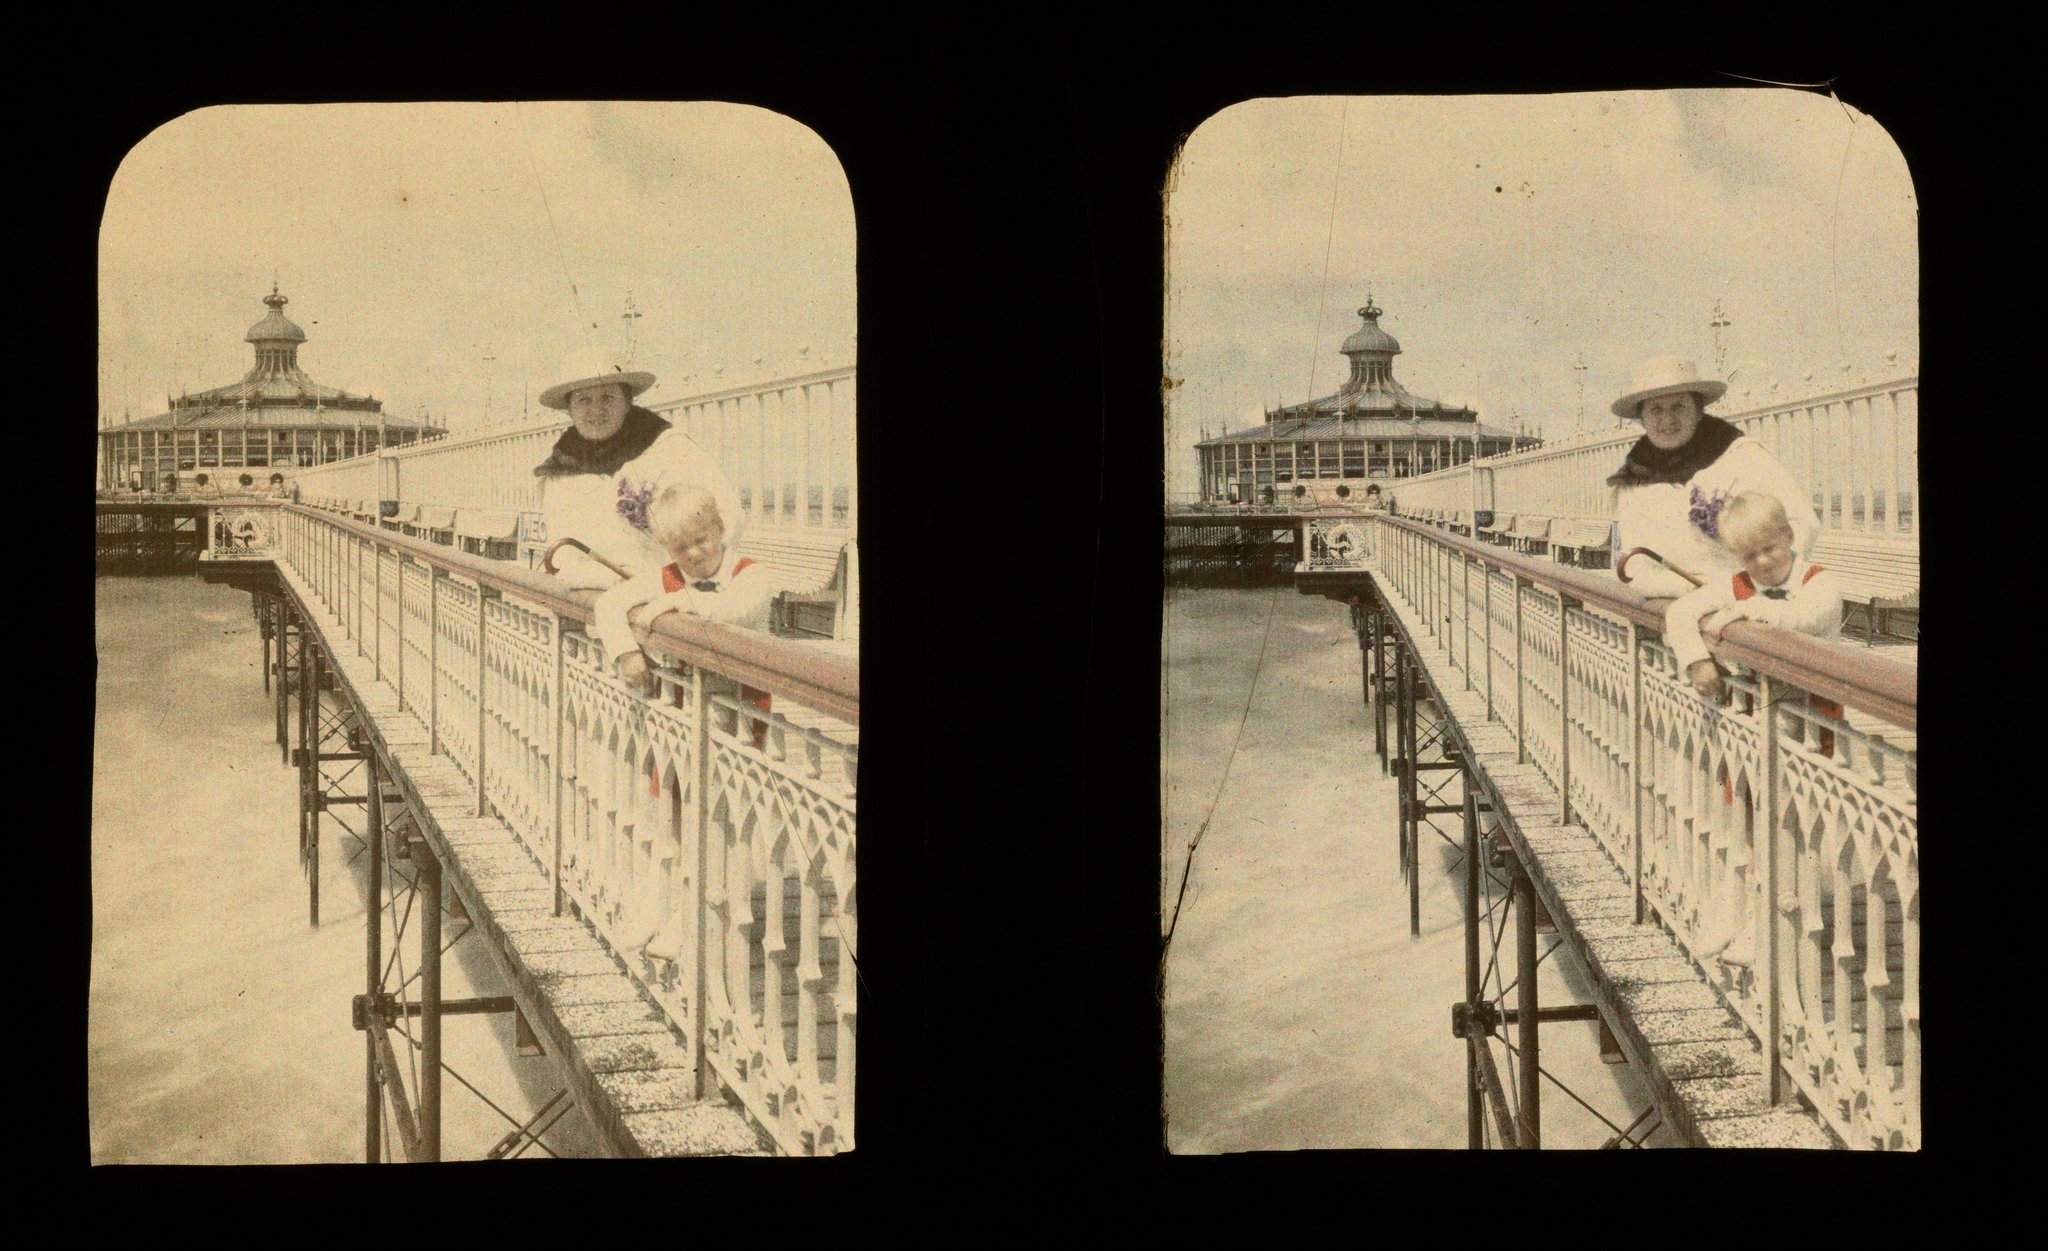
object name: photograph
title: Pier van Scheveningen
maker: Anonymous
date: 1920-1935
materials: glass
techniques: autochrome process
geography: scheveningen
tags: pier, quay, wharf